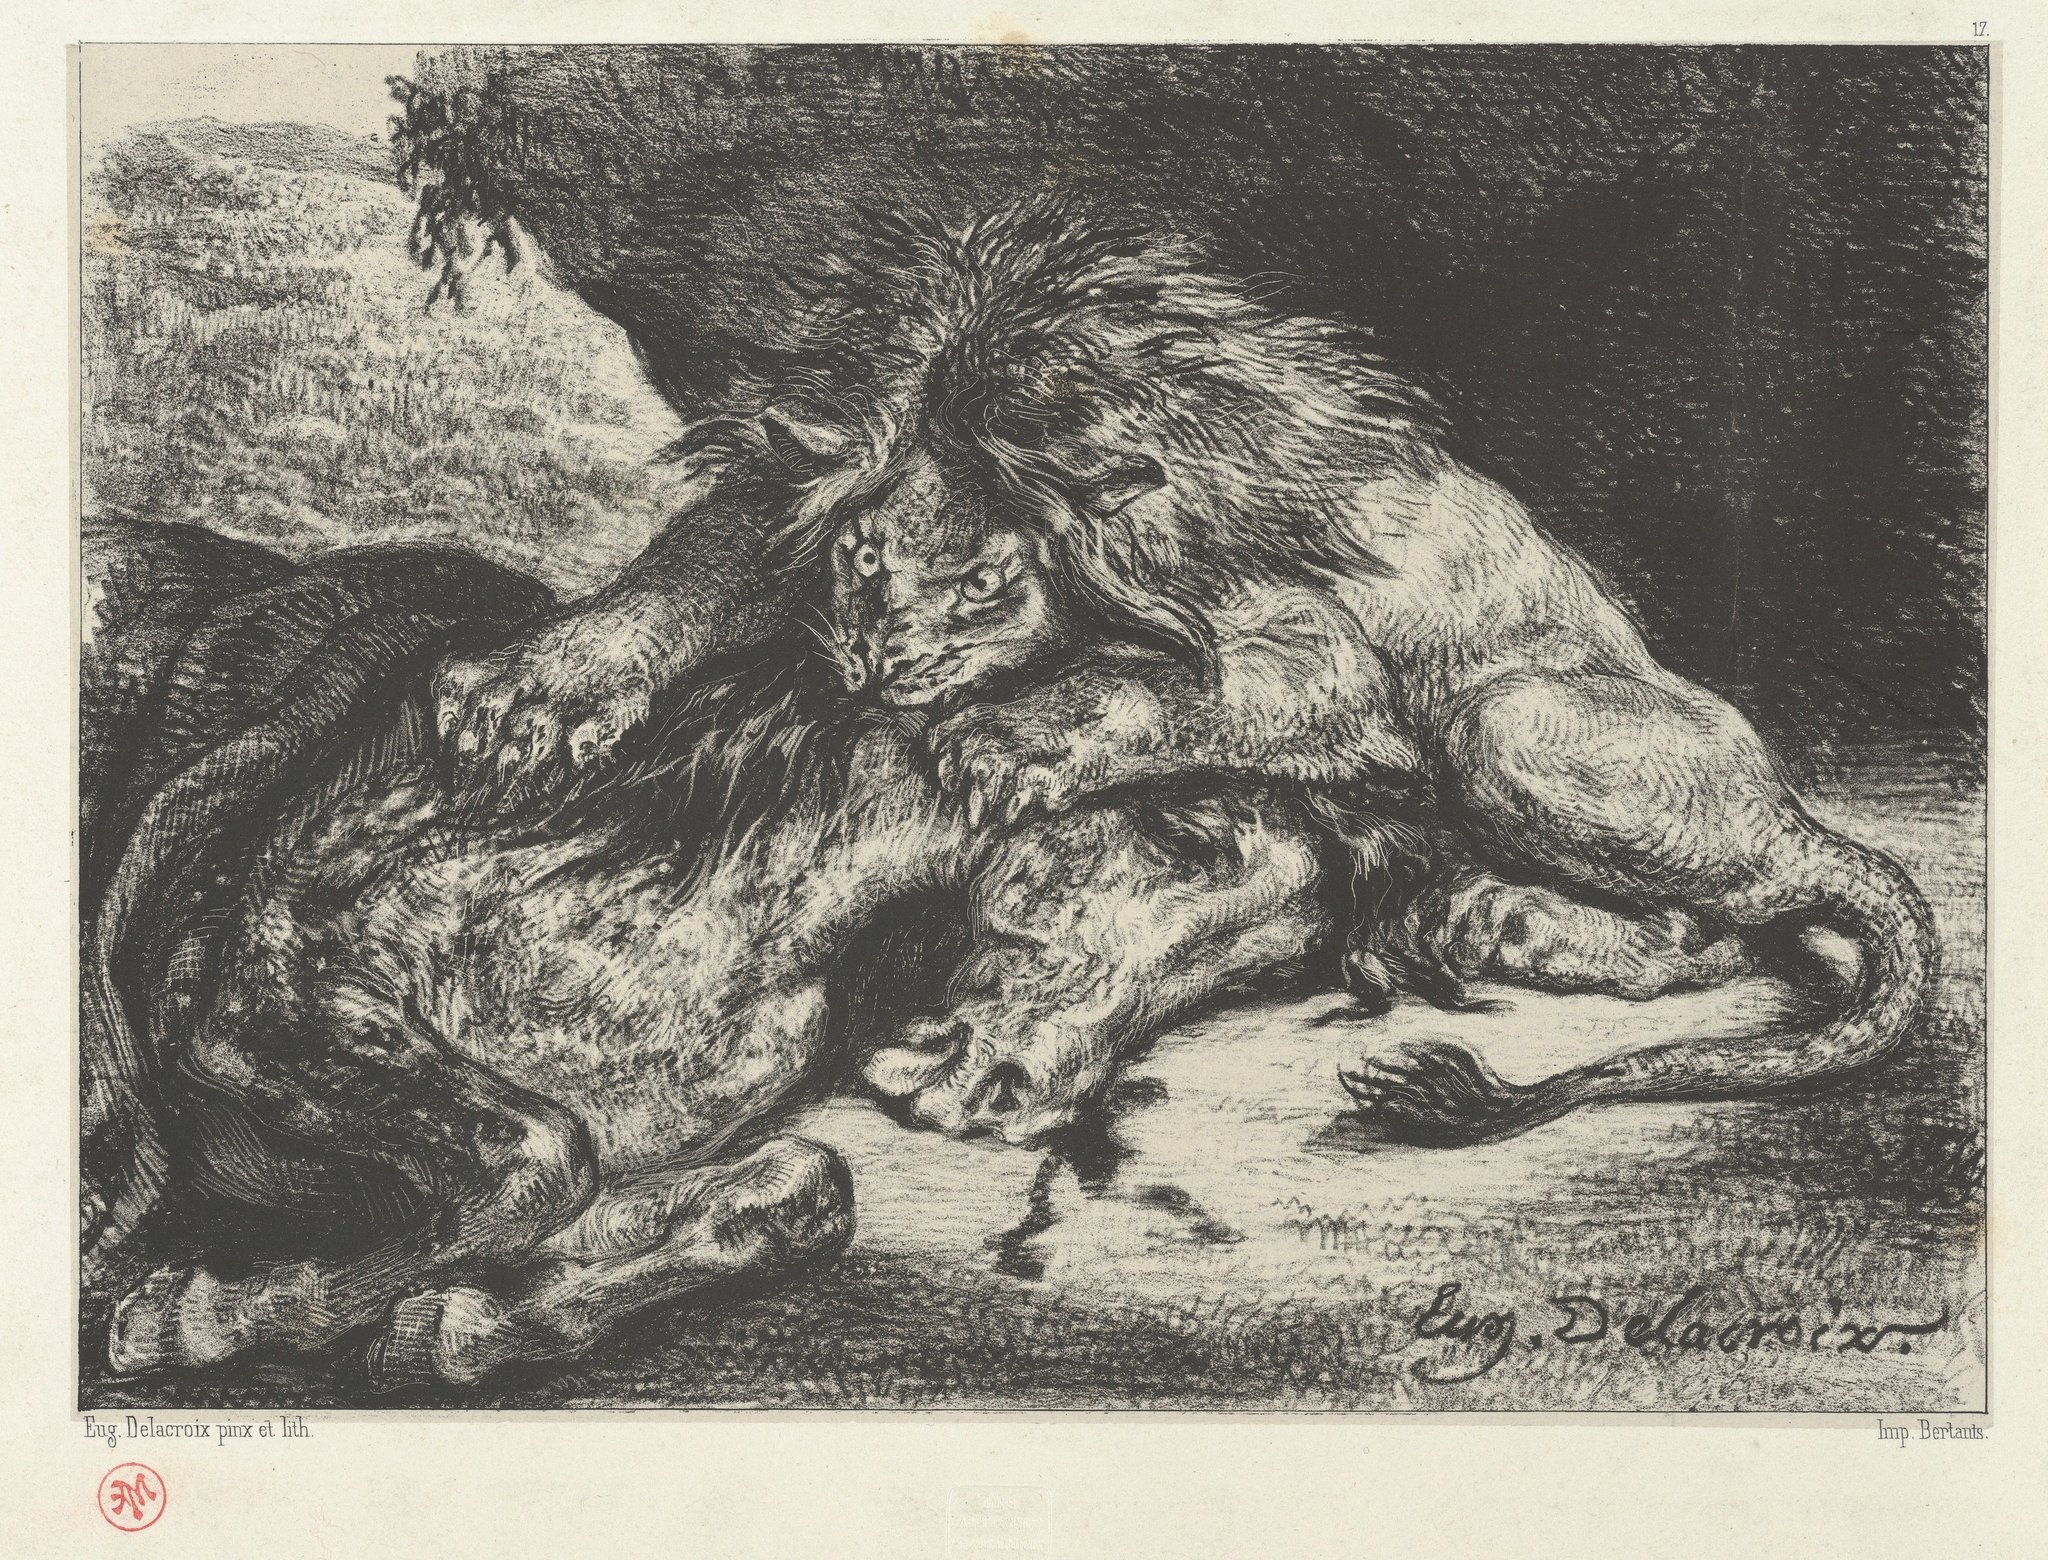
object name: print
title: Lion Devouring a Horse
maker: eugène delacroix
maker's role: artist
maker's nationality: french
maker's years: 1798-1863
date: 1844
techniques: printmaking, lithograph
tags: horses,lions